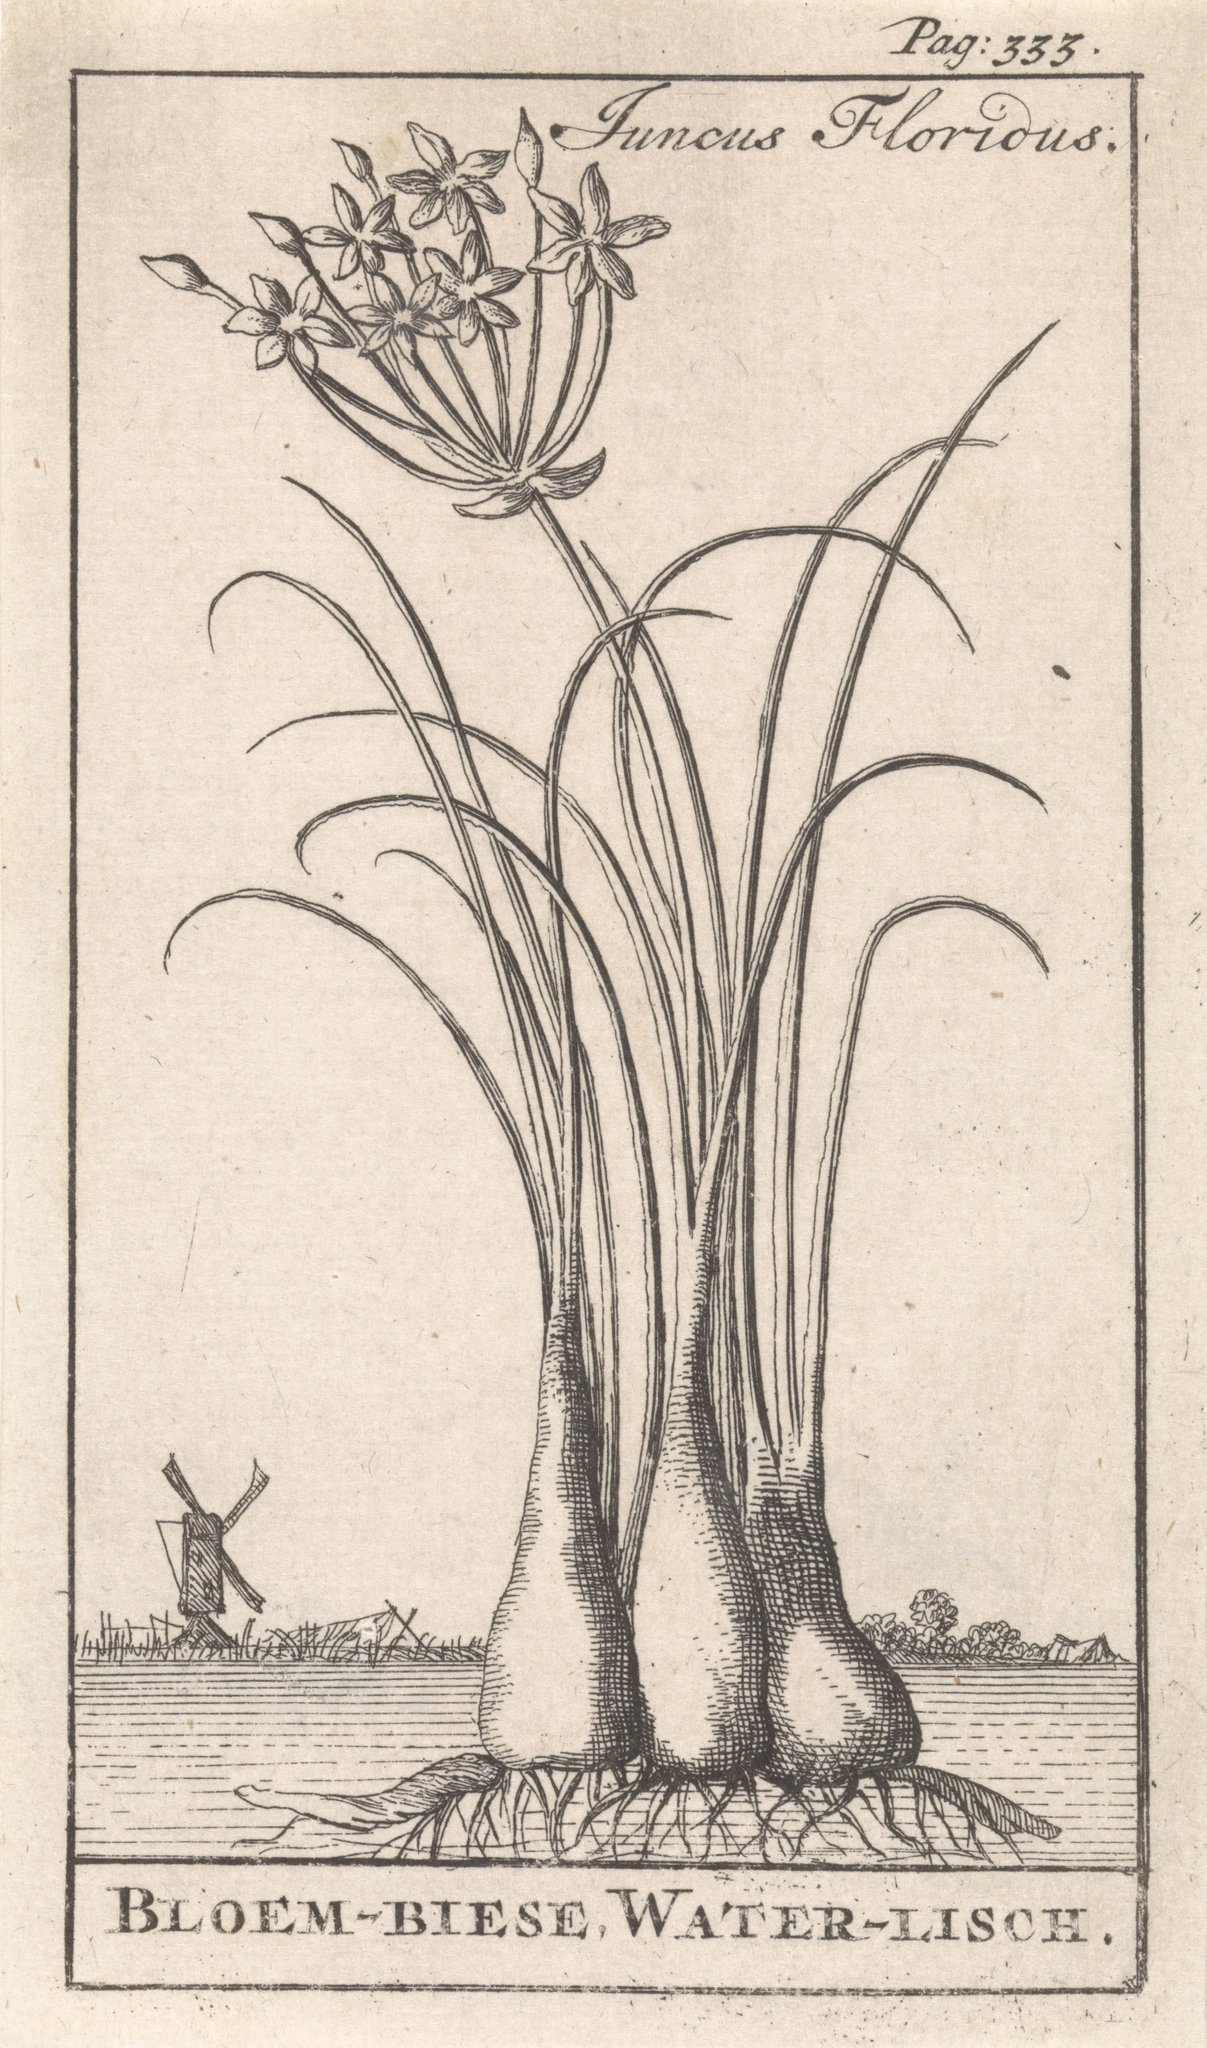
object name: print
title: Iuncus Floridus / Bloem-biese. Water-lisch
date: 1698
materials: paper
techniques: etching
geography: amsterdam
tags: plants and herbs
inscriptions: collector's mark: Lugt 2228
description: Illustratie uit: Blankaart, Steven. Den Neder-landschen herbarius ofte Kruid-boek der voornaamste kruiden. Amsterdam: Jan Claesz ten Hoorn, 1698.